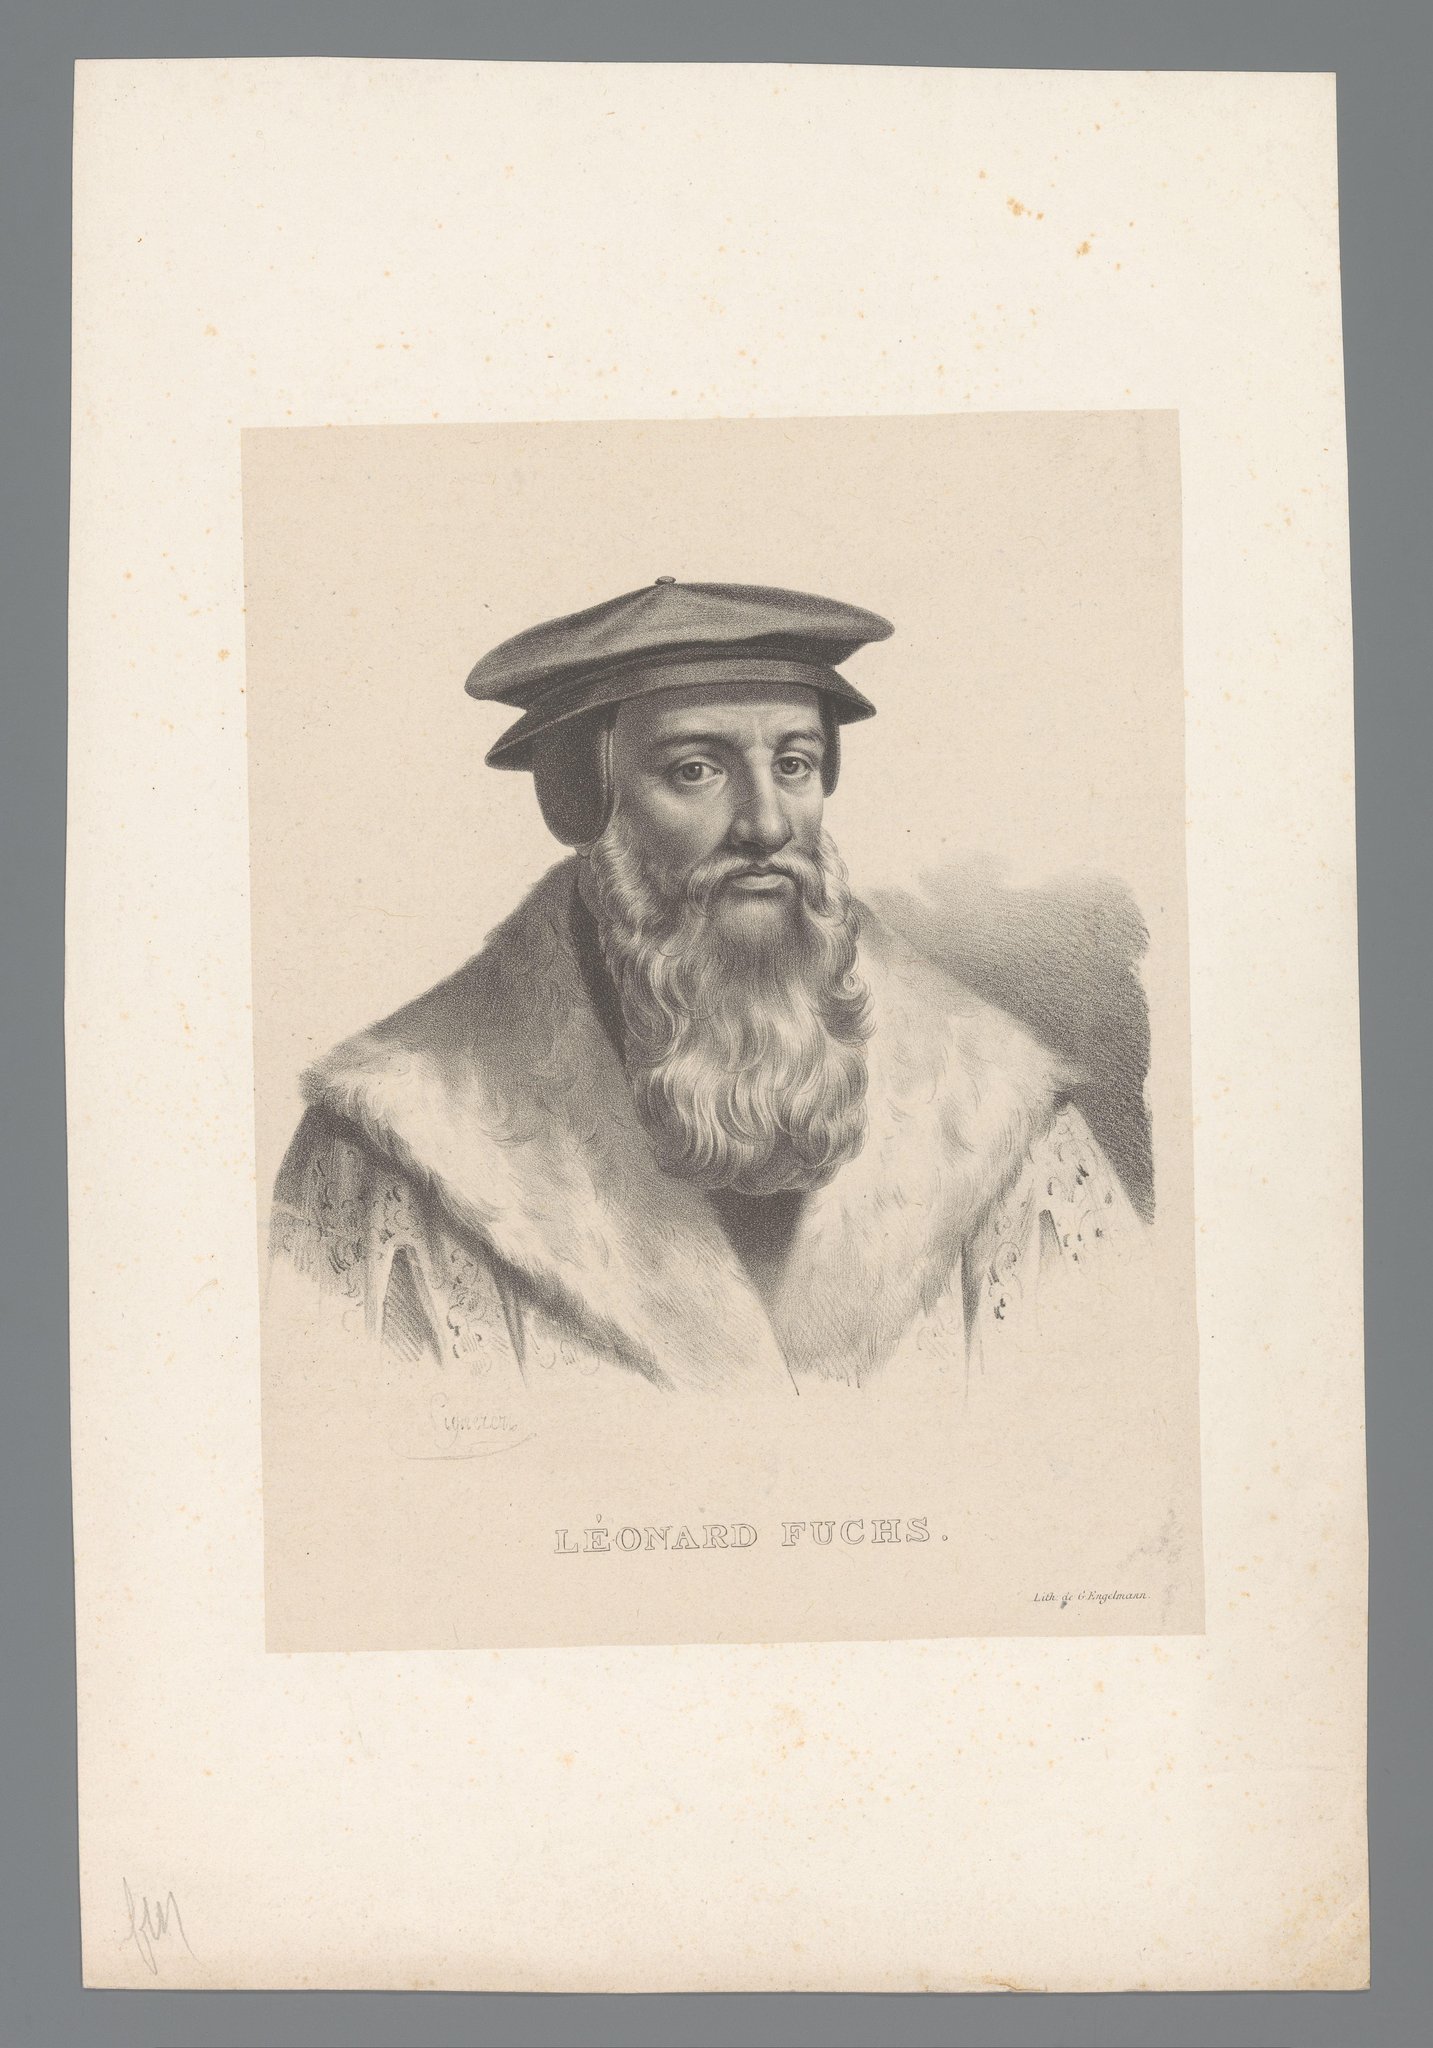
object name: print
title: Portret van Leonhart Fuchs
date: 1816-1833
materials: paper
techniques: lithograph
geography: paris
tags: historical persons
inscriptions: collector's mark: Lugt 2228